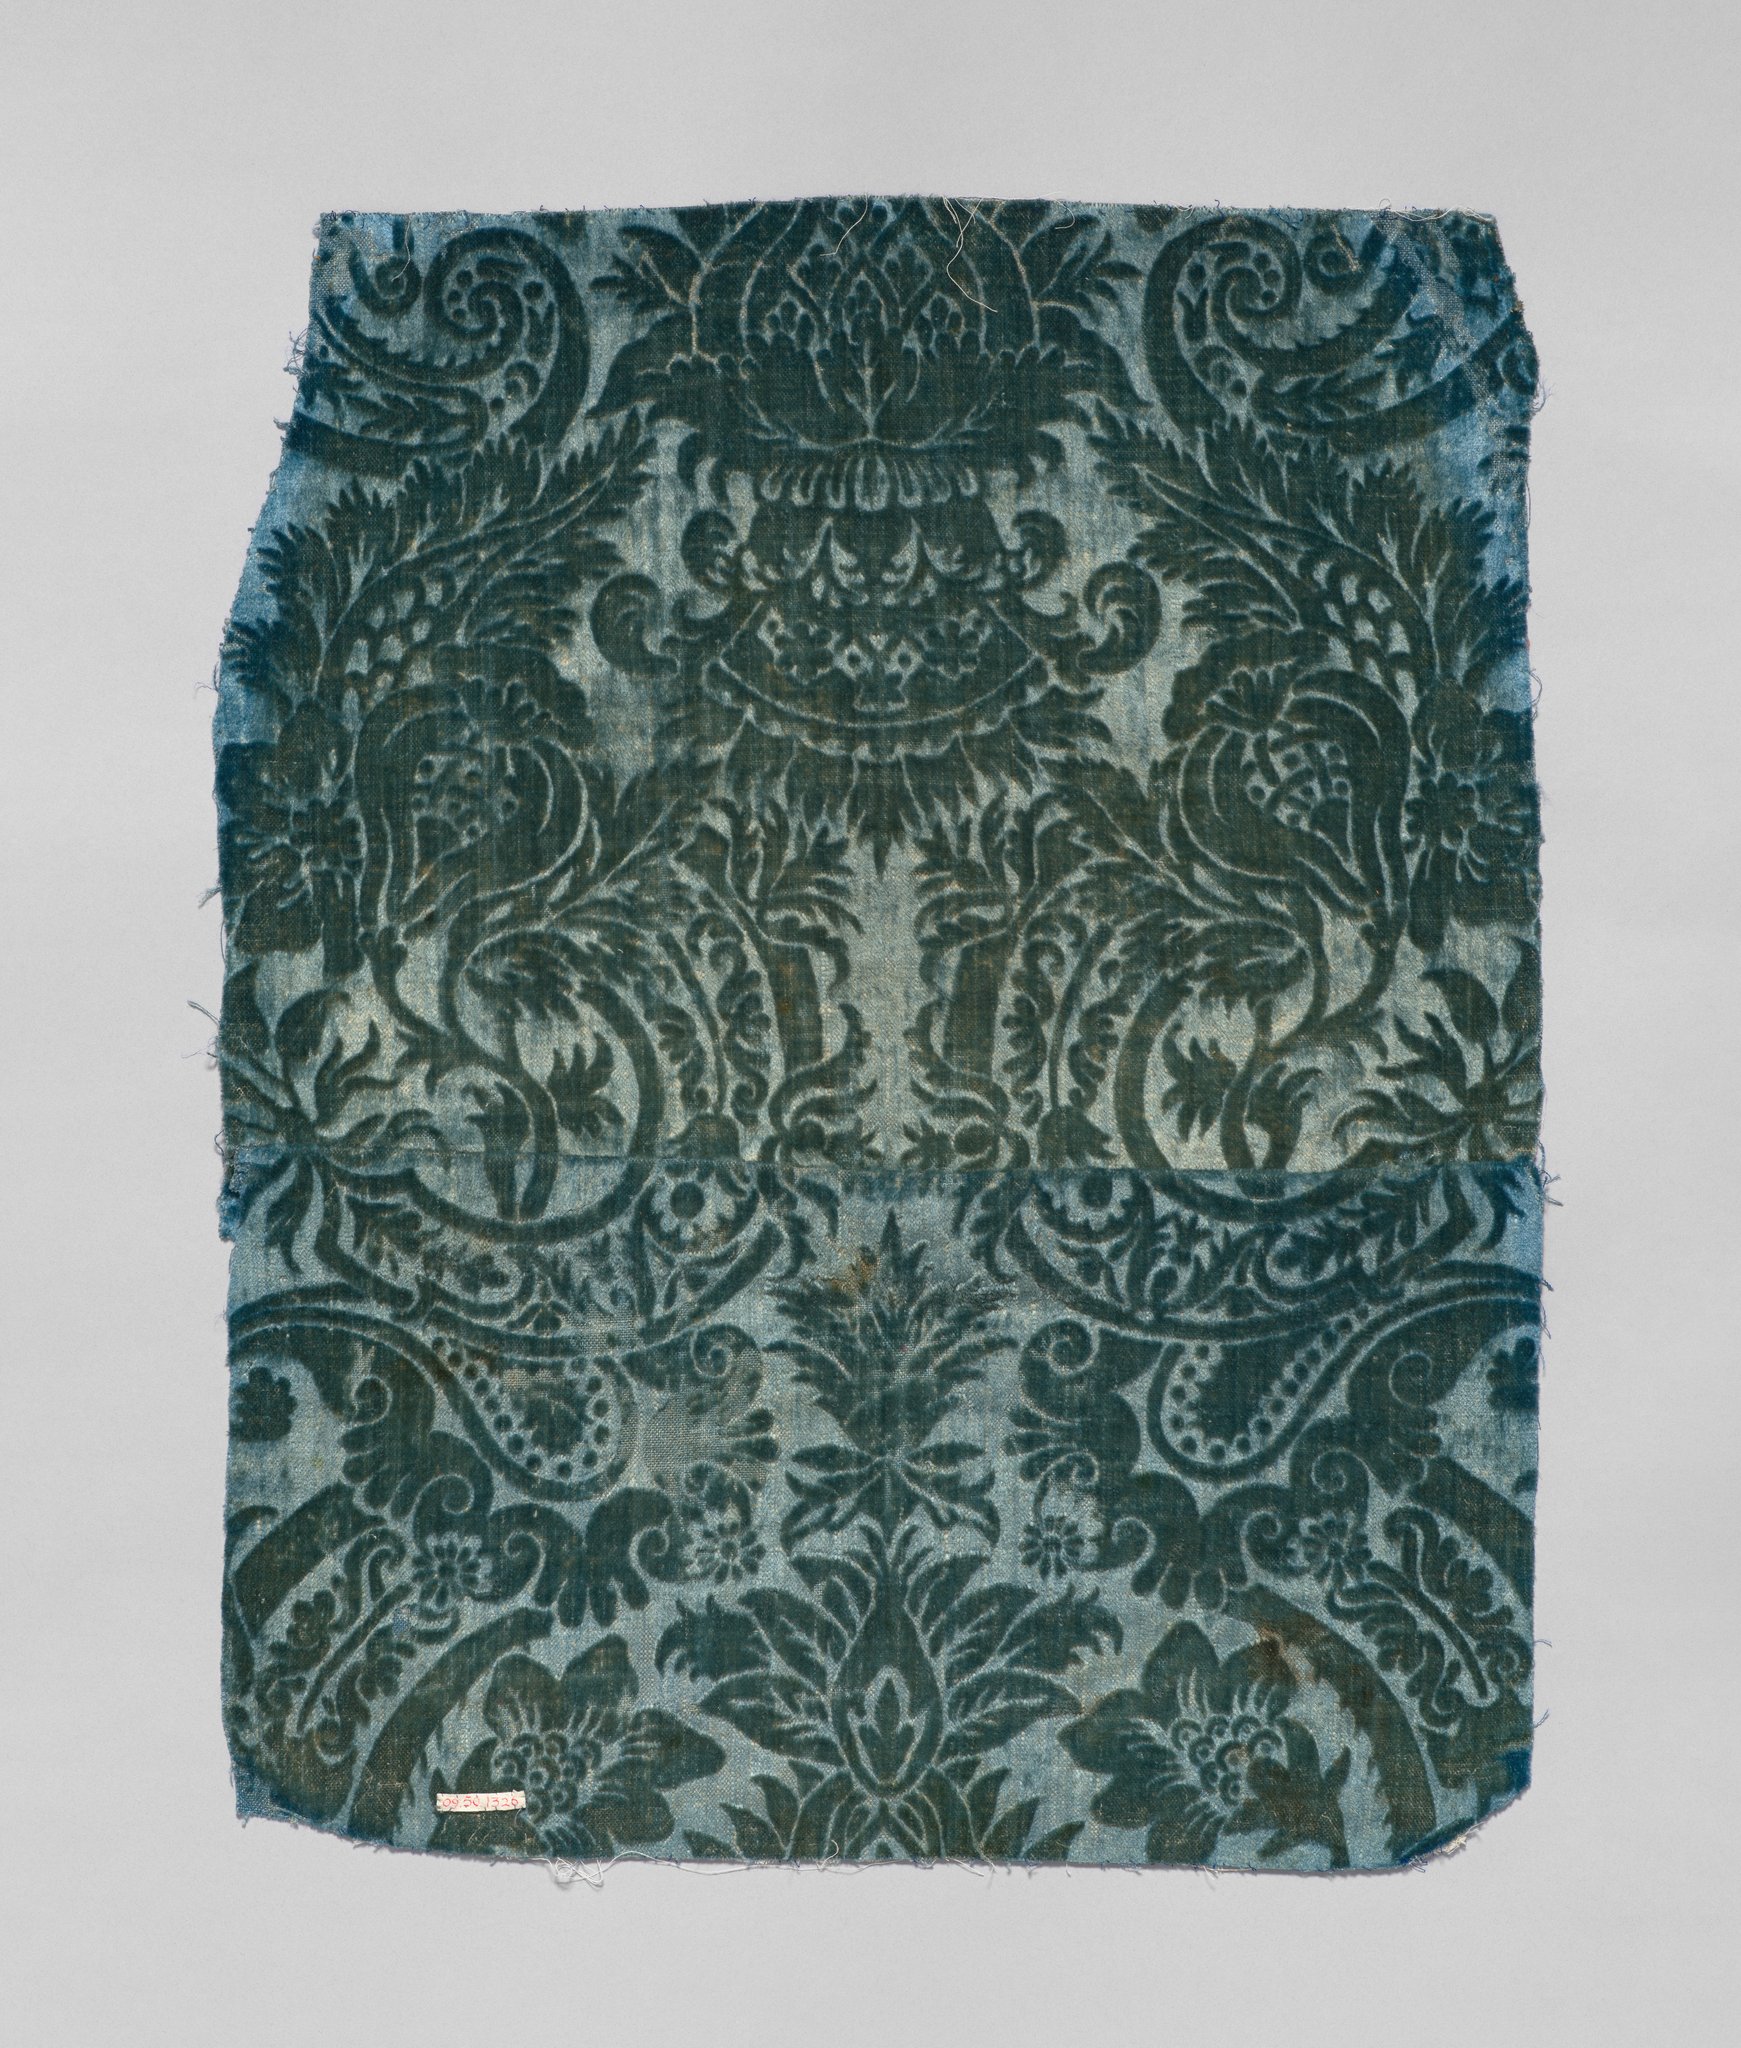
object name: piece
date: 1601-1700